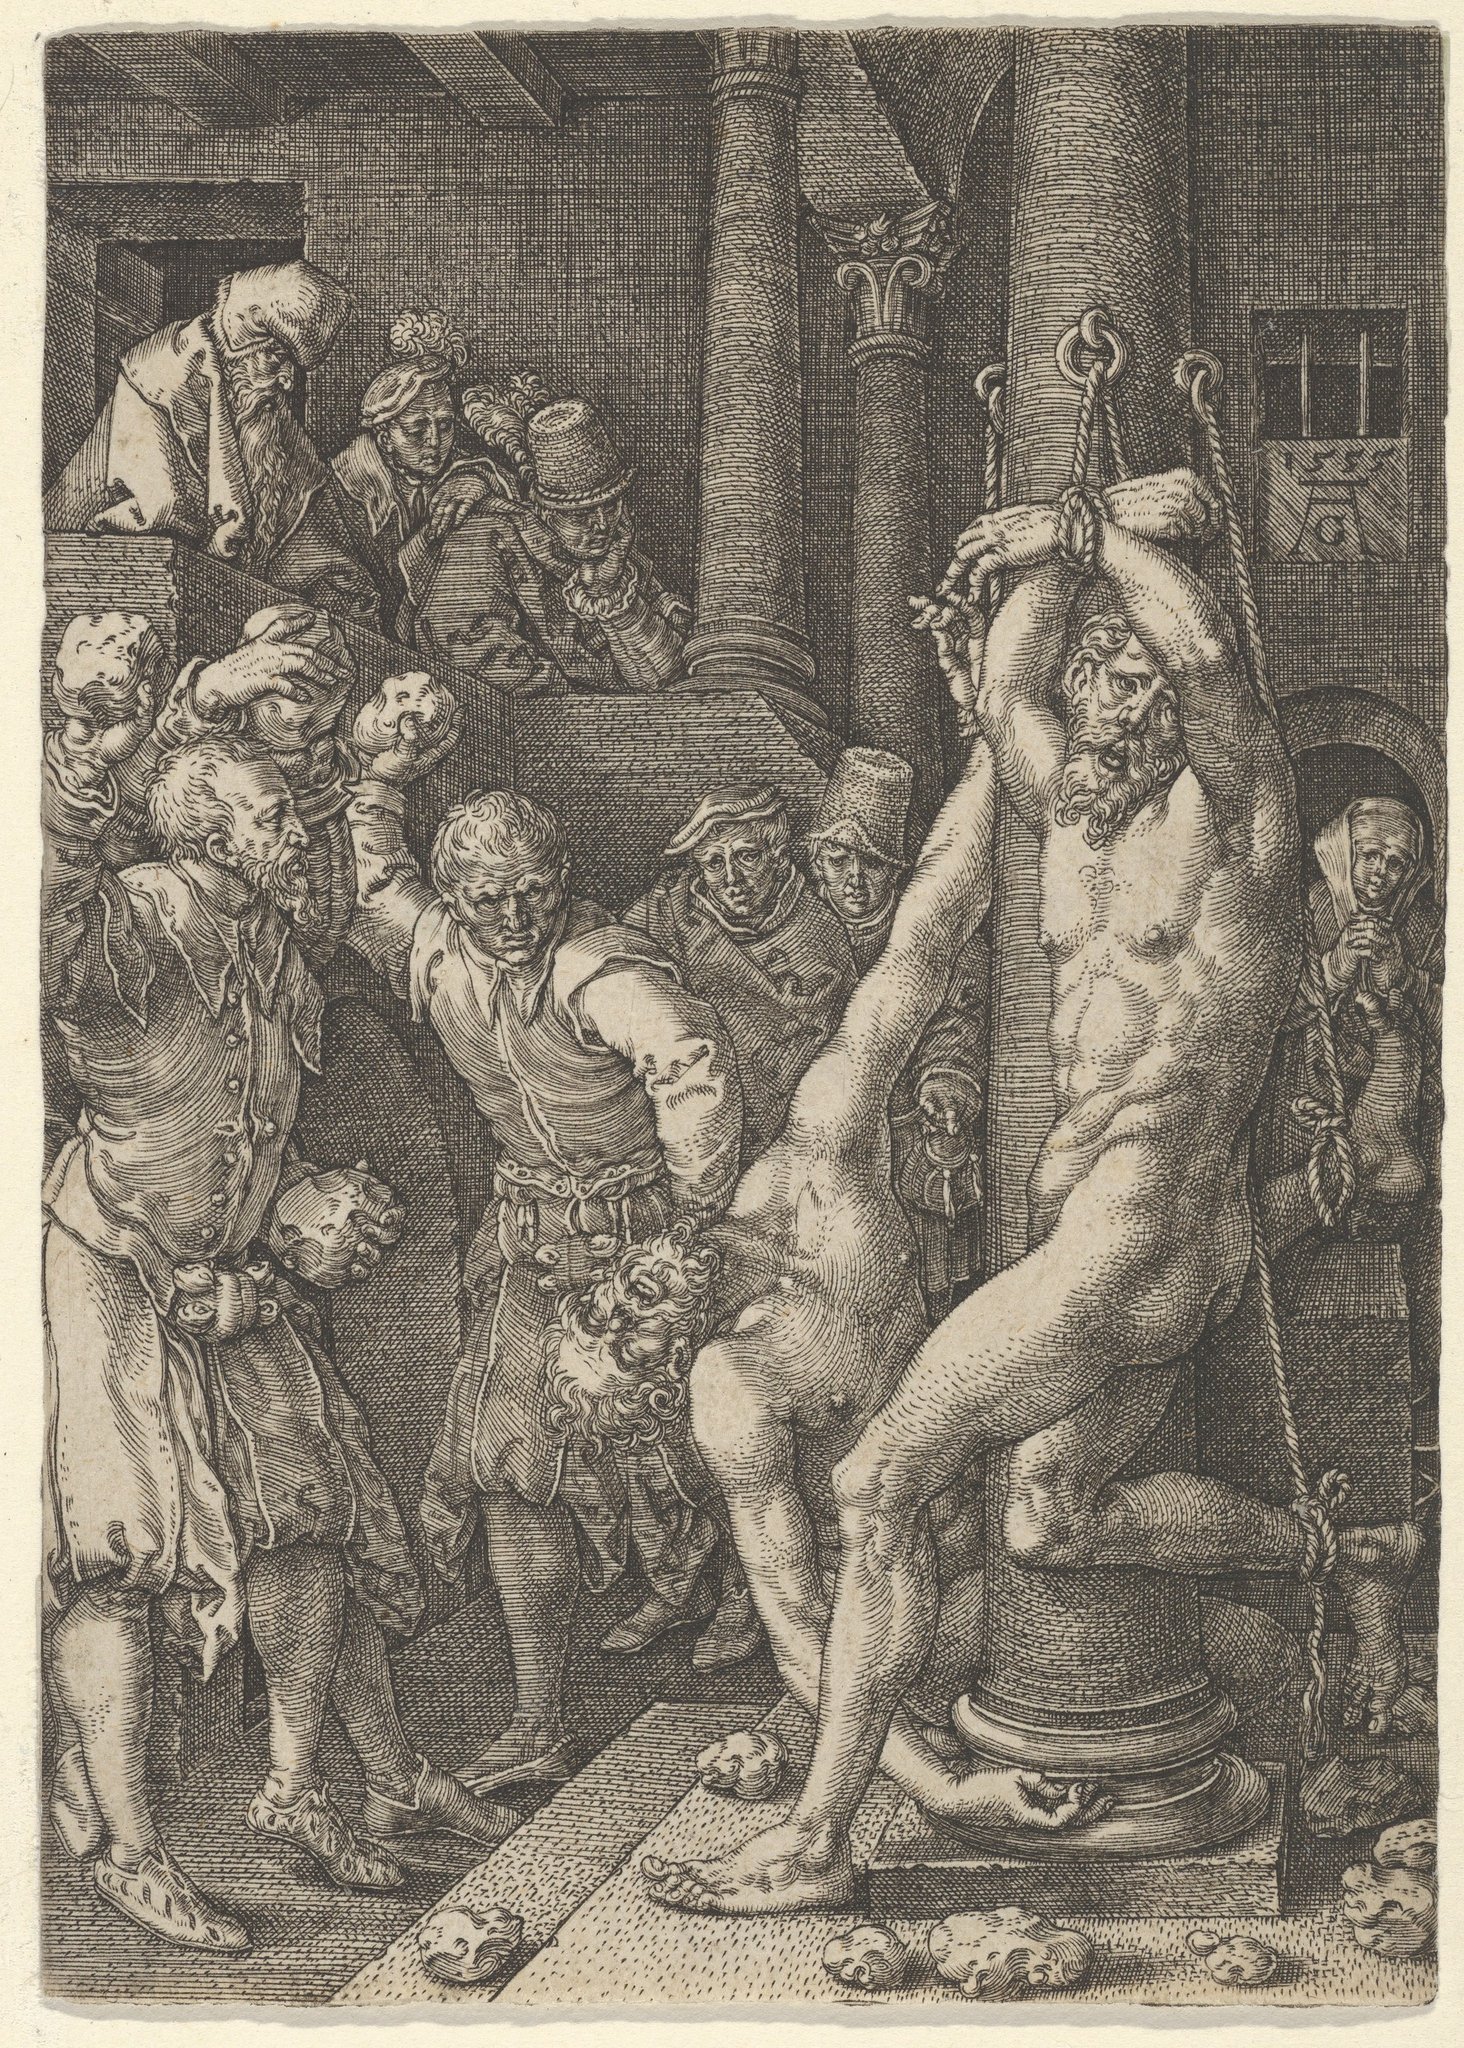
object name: print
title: The Stoning of the Elders, from The Story of Susanna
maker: heinrich aldegrever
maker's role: artist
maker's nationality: german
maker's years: 1502-1561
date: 1555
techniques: engraving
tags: suffering,men,male nudes